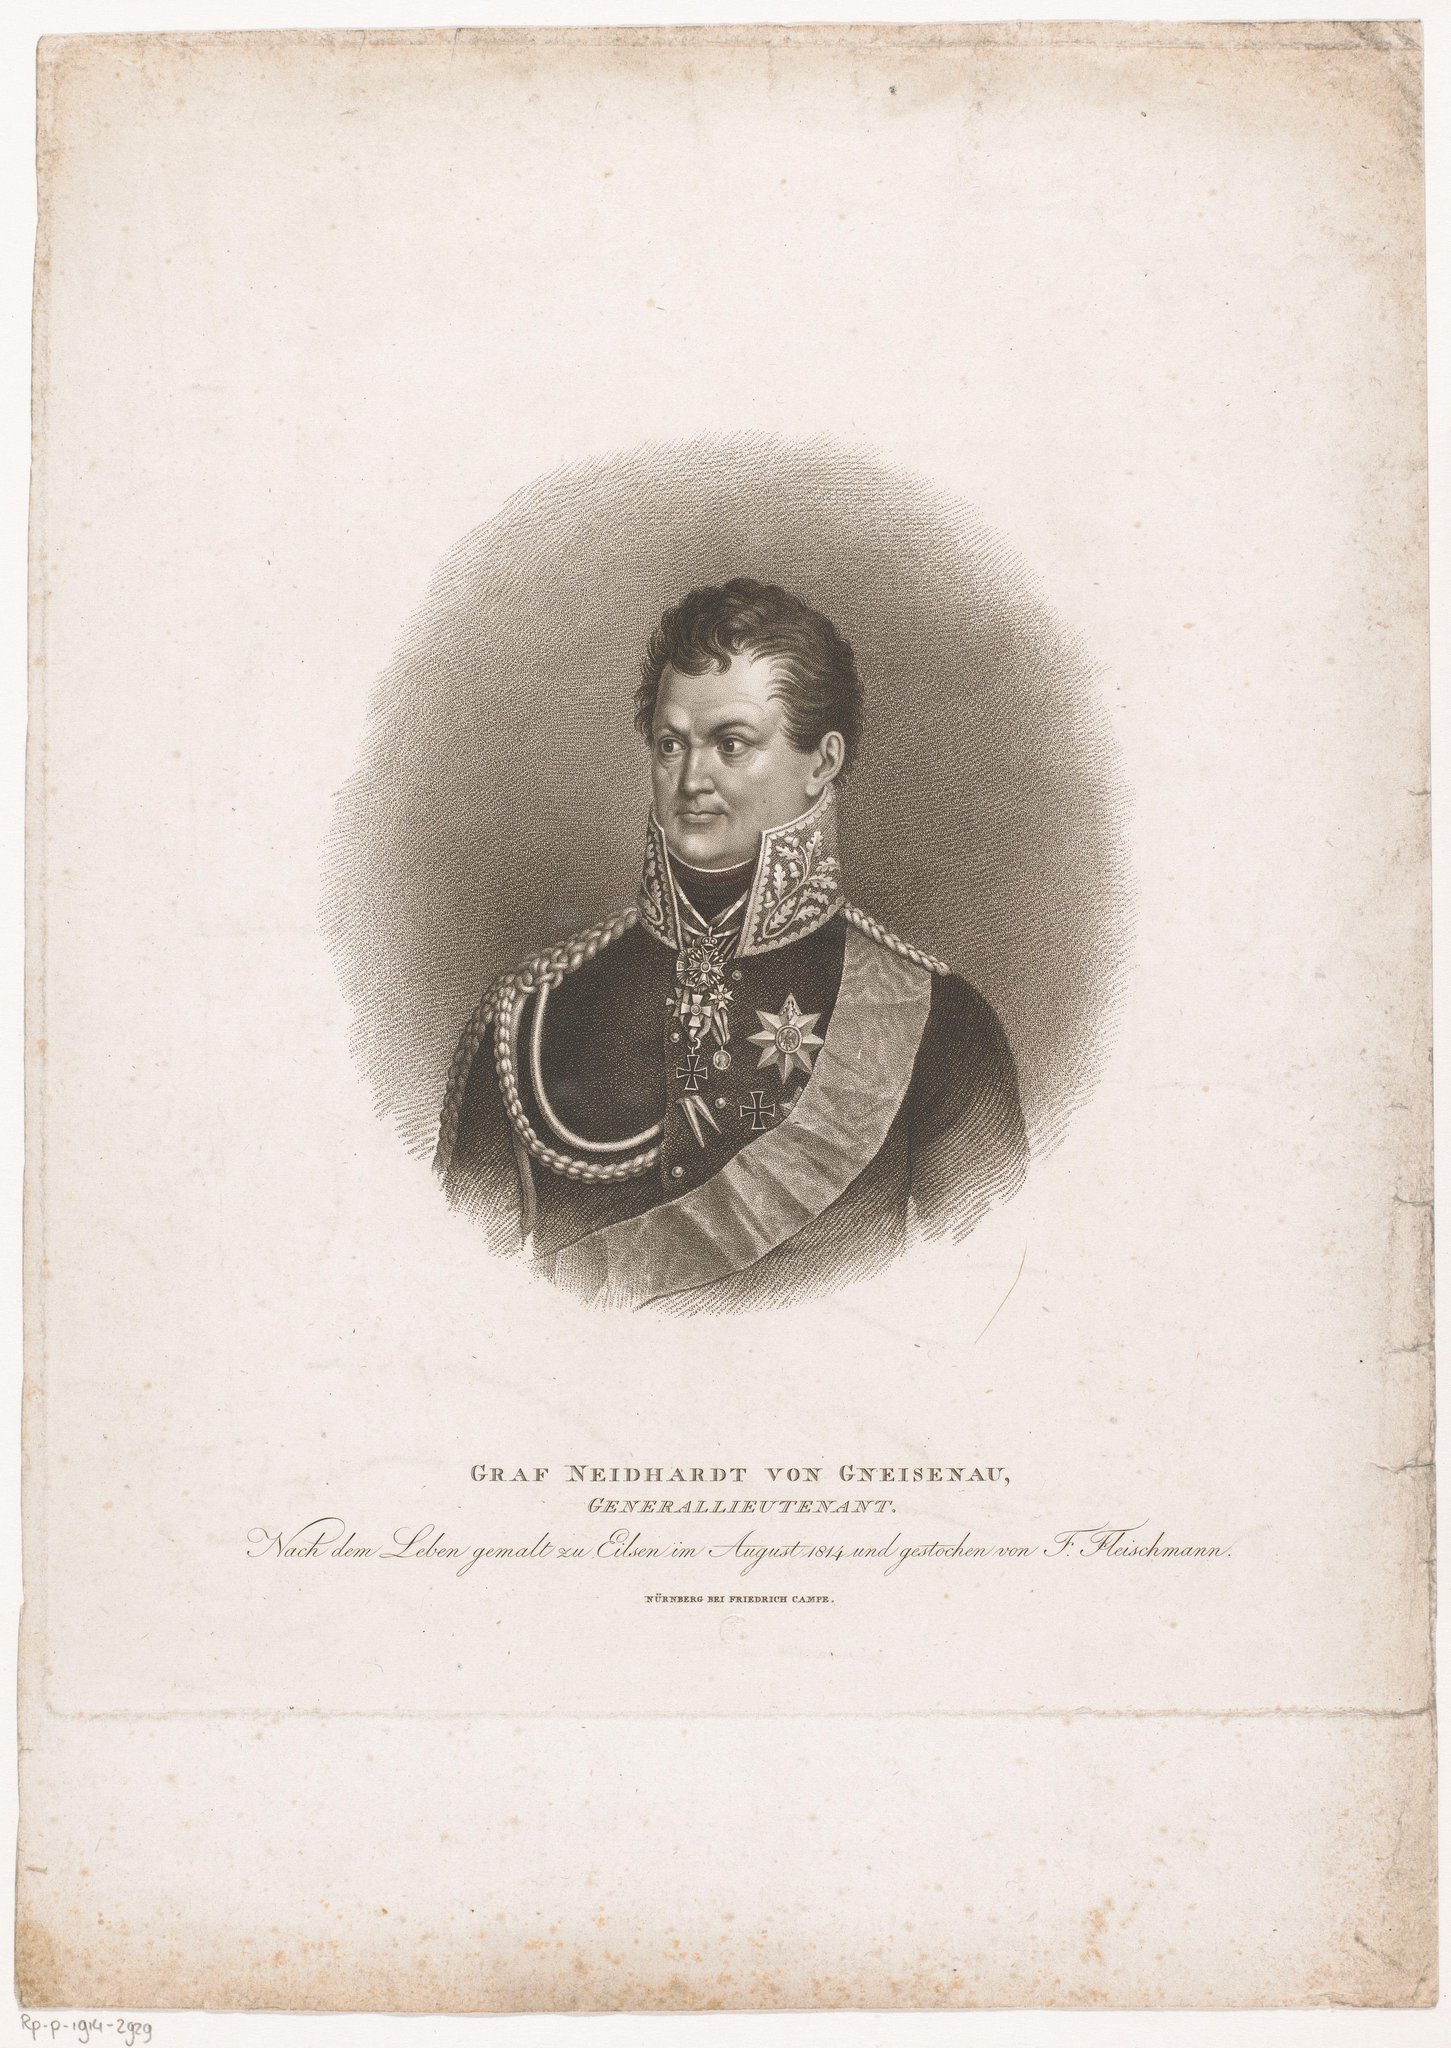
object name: print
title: Portret van August Wilhelm Antonius Neidhardt Graf von Gneisenau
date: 1808-1814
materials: paper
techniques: roulette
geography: nuremberg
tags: historical persons, medals and other marks of military honour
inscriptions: monogram: ‘F. C., monogram van drukkerij Friedrich Campe te Neurenberg.’, collector's mark: Lugt 2228